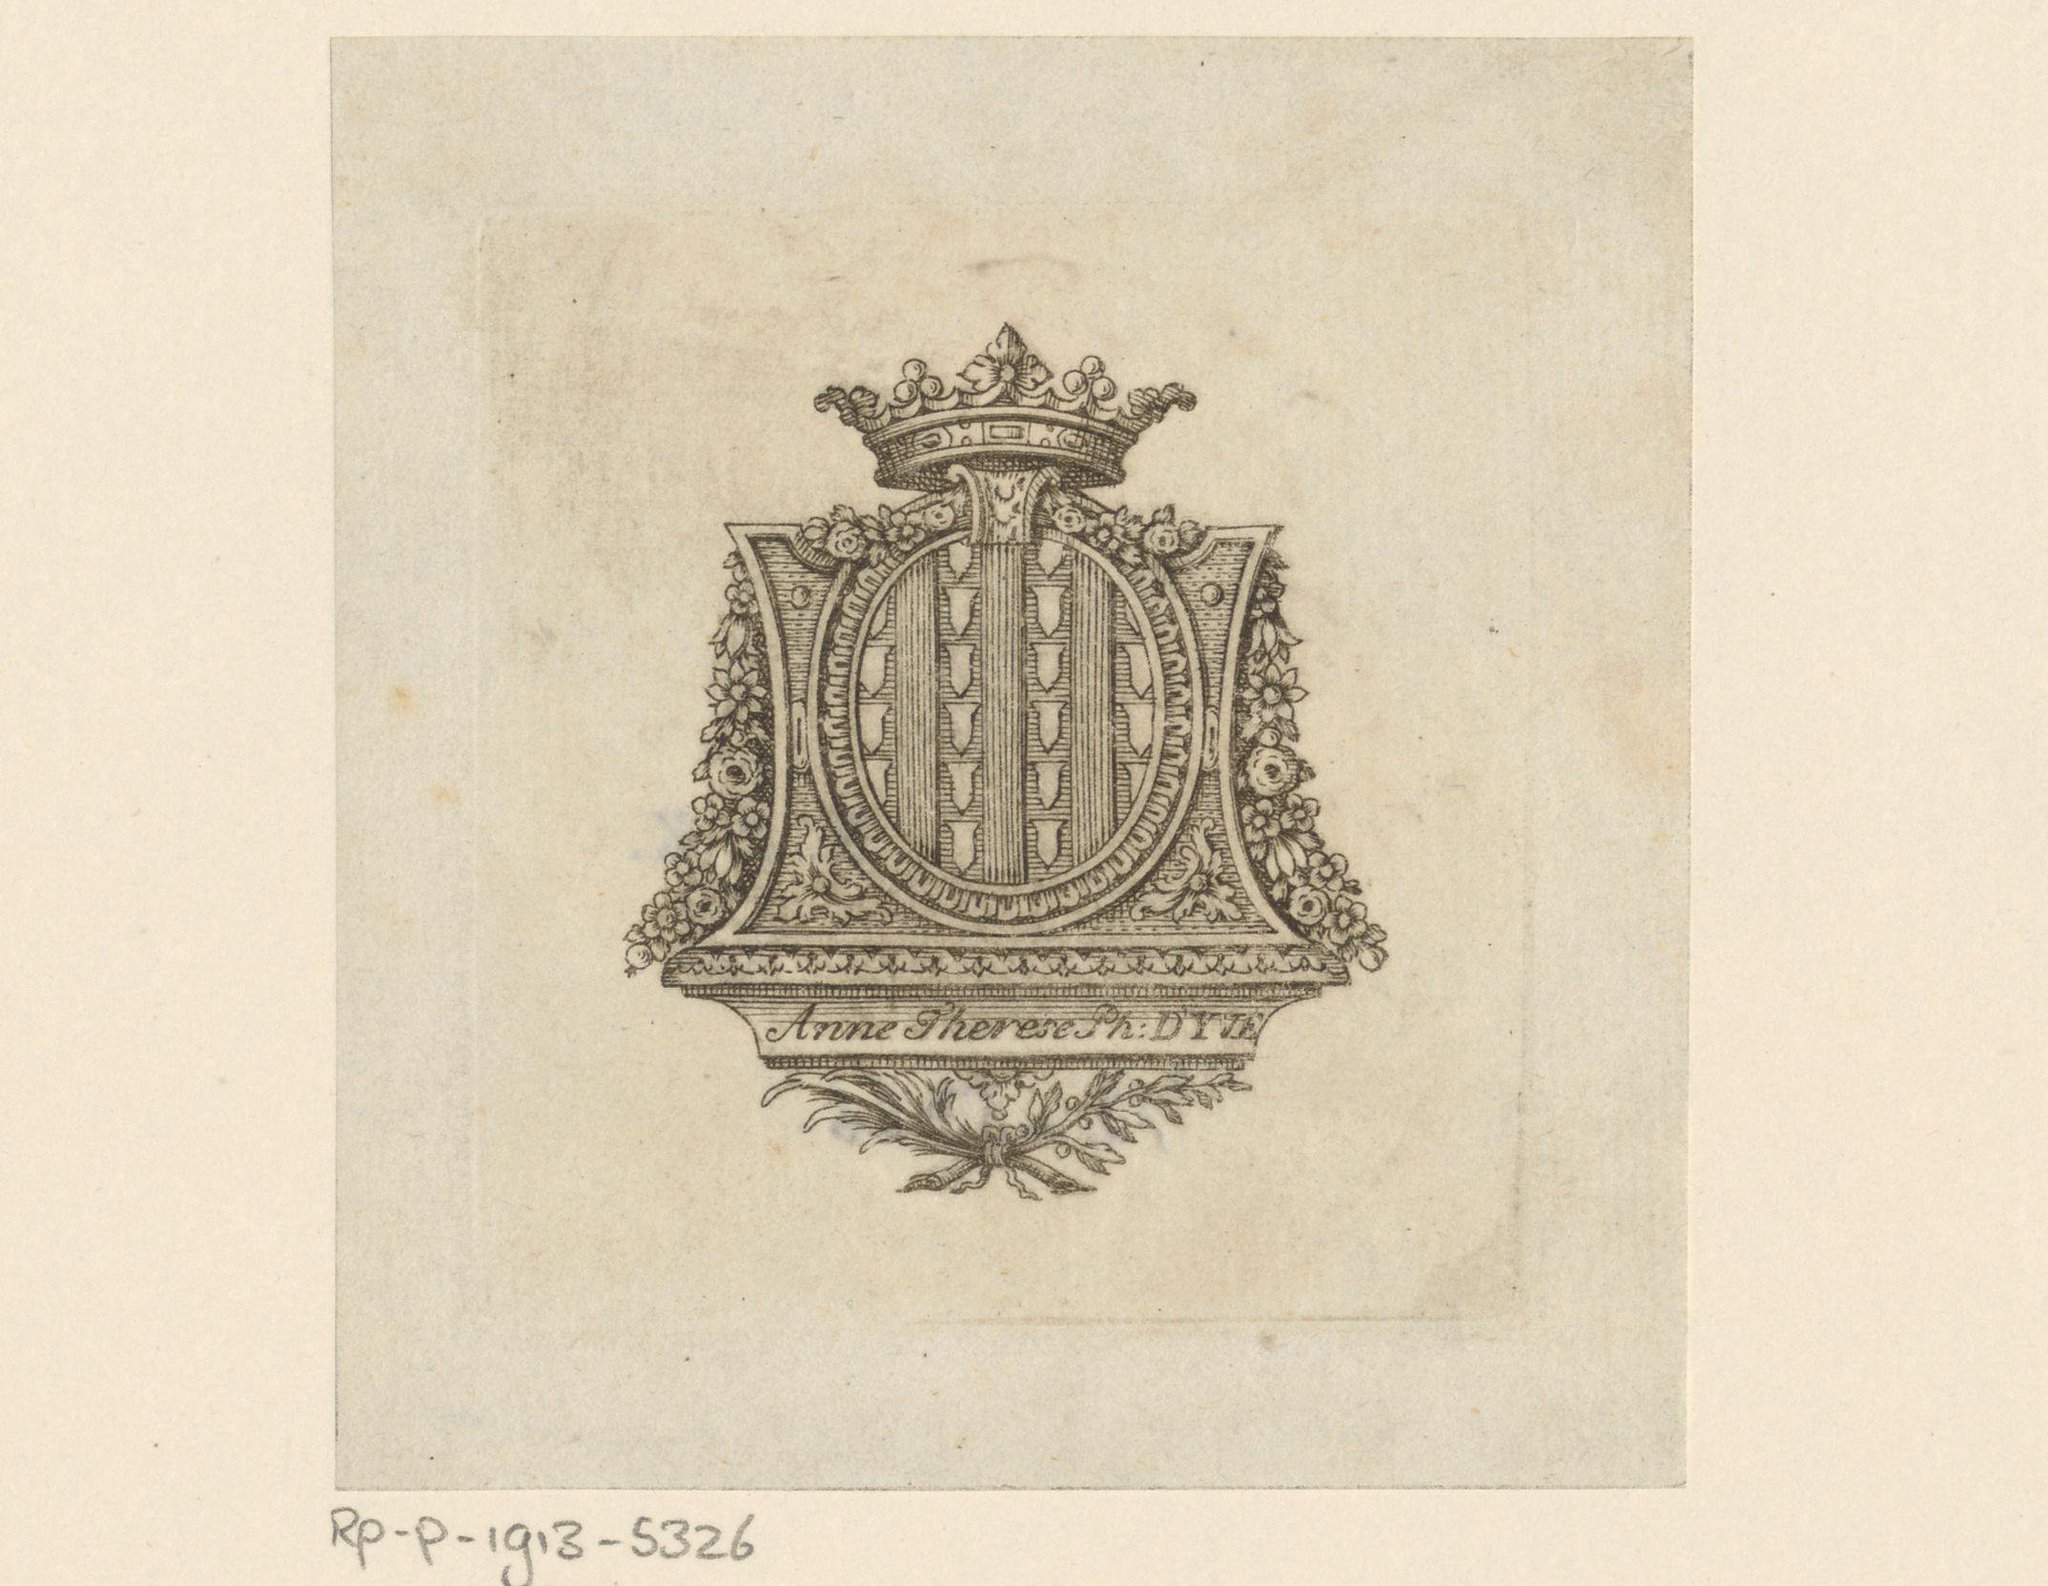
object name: bookplate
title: Ex libris van Anne Therese Ph: d'Yve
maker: Anonymous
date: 1748-1814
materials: paper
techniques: engraving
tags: armorial bearing, heraldry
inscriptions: collector's mark: Lugt 2233, collector's mark: Lugt 2760